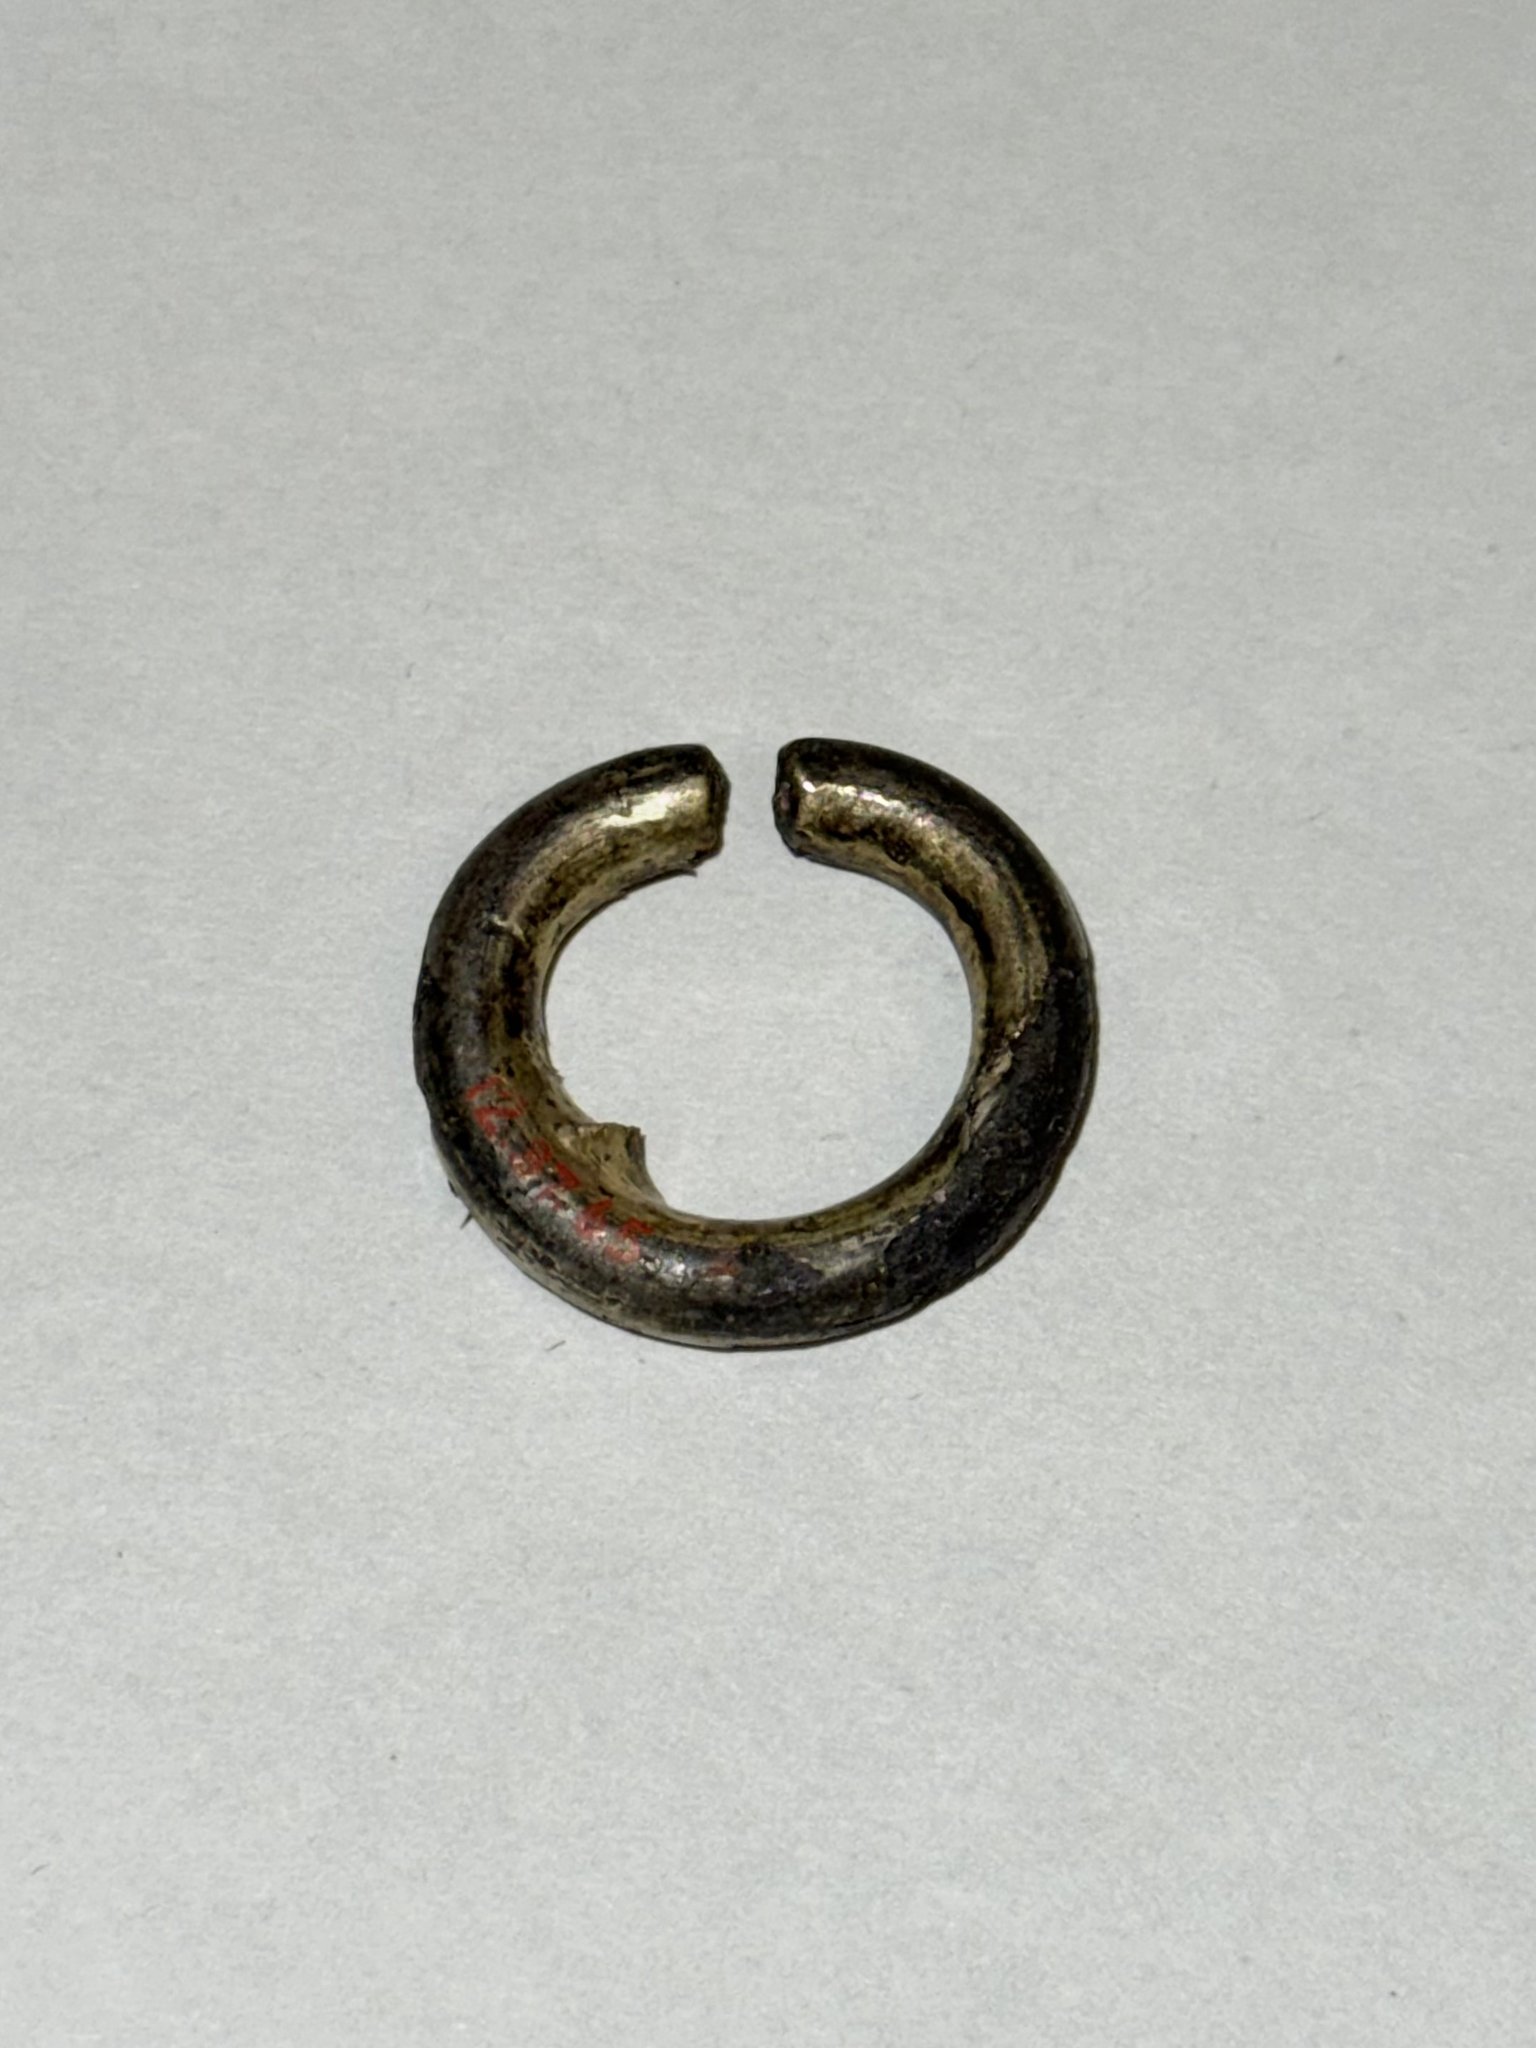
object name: earring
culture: japanese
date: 601-700